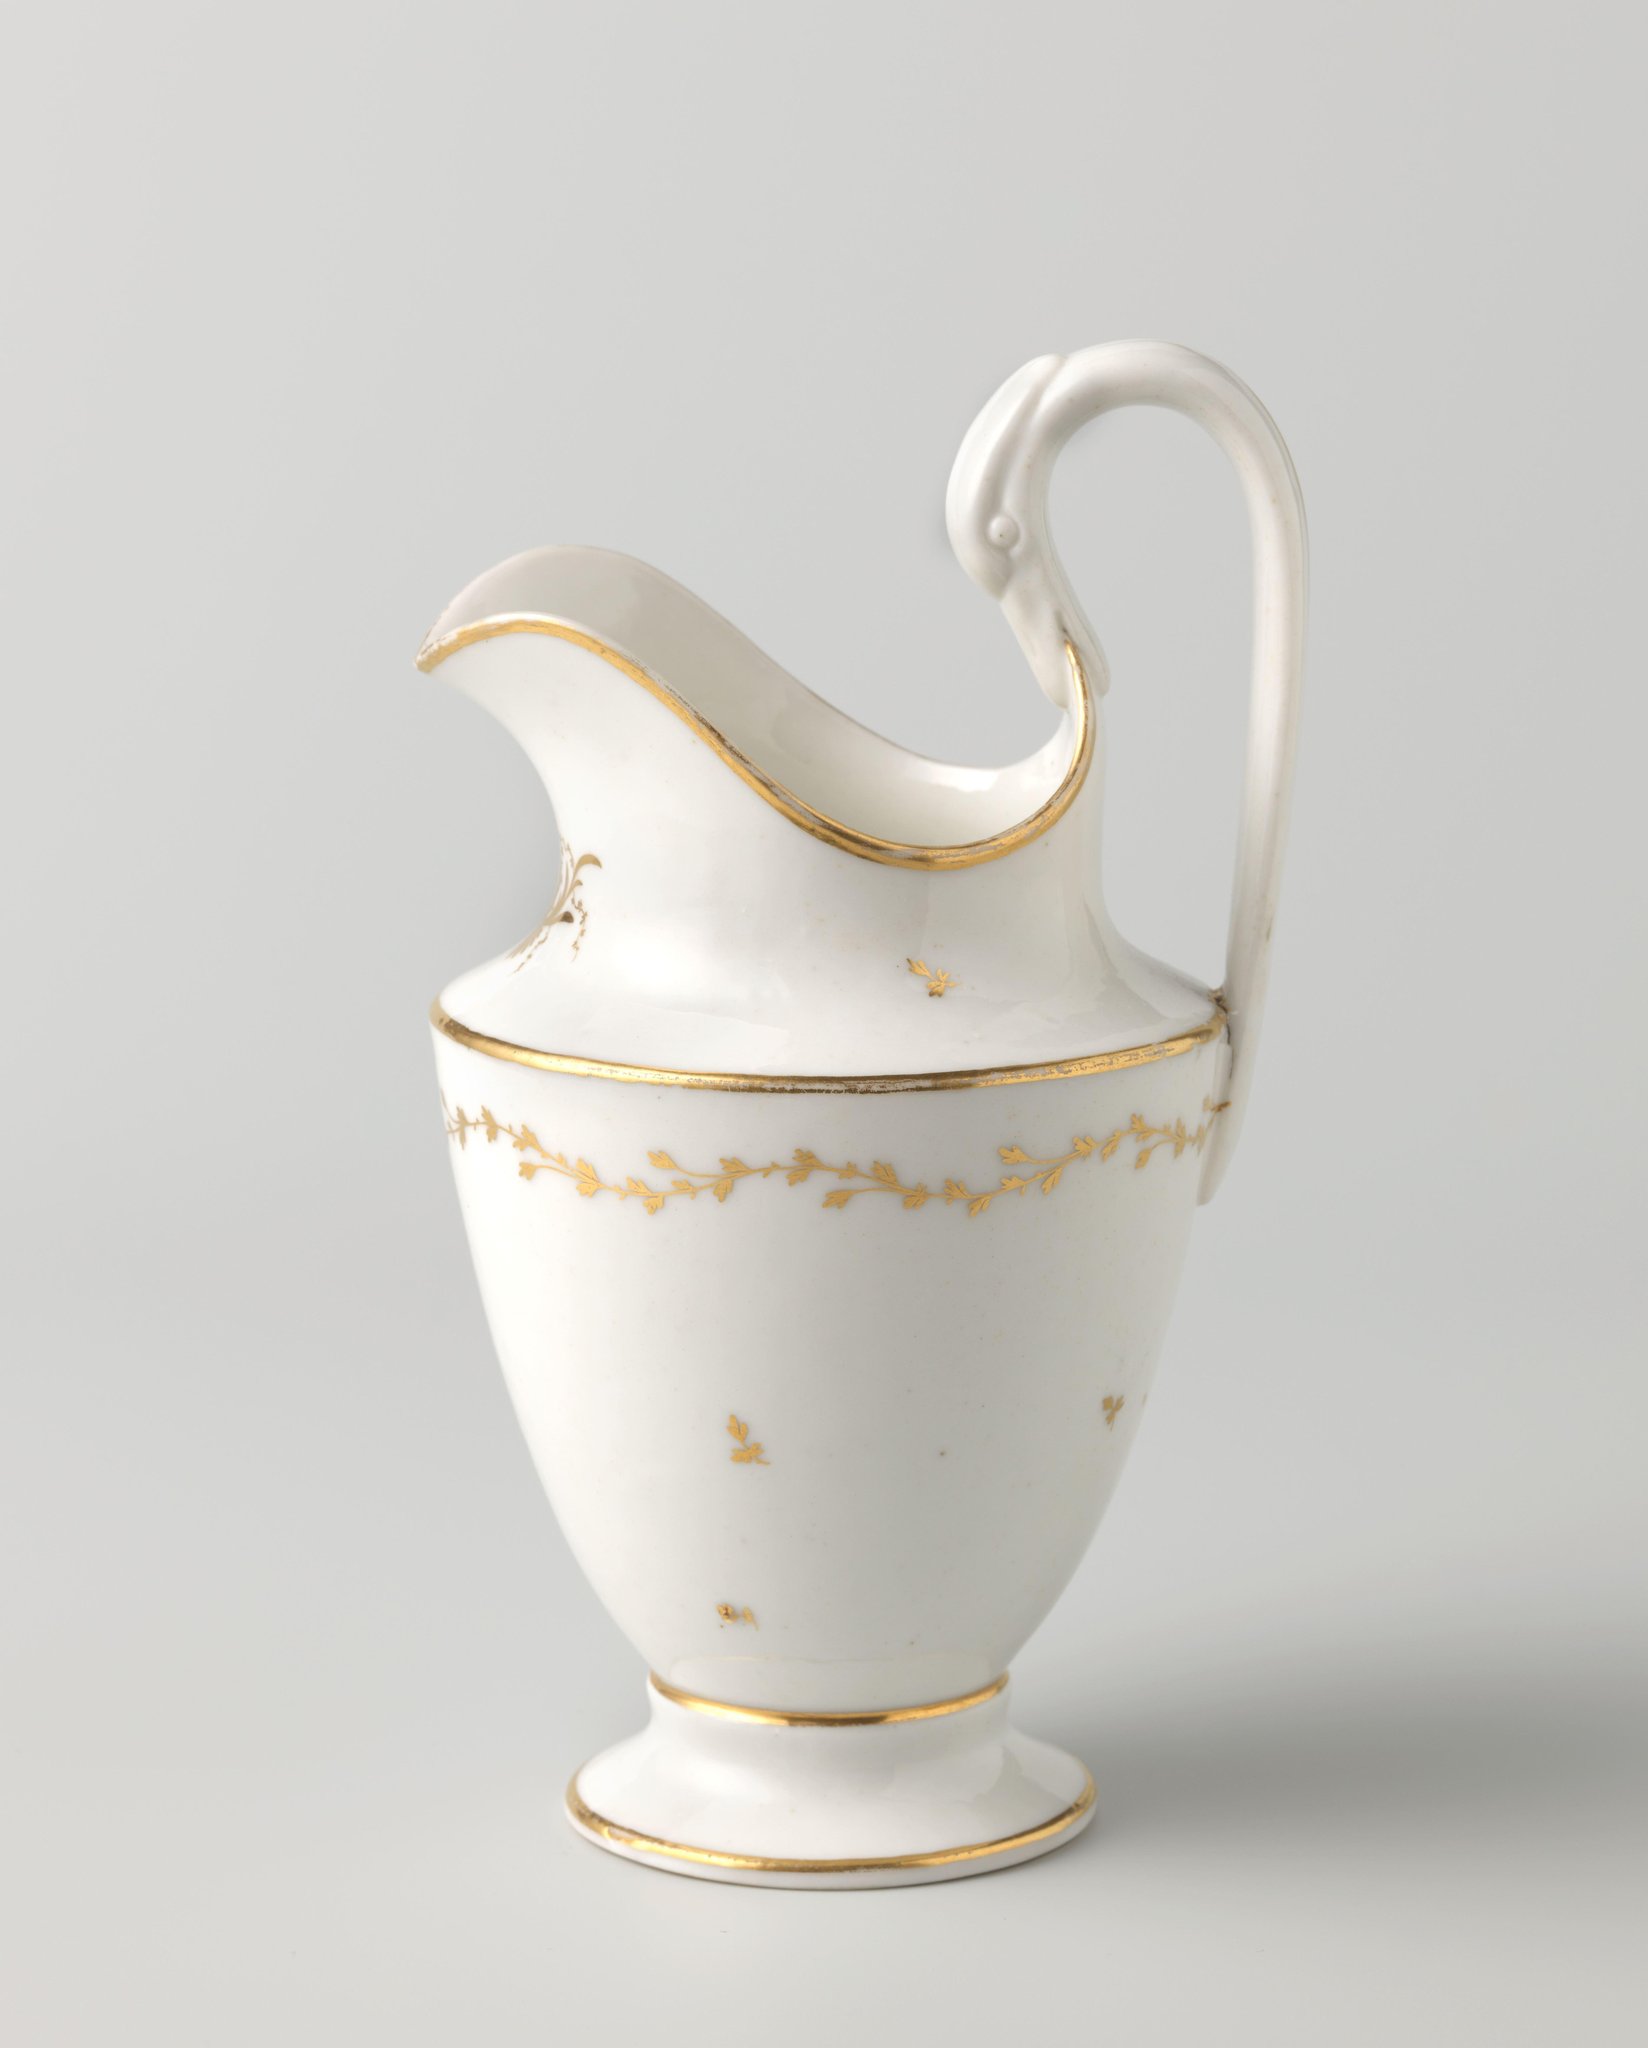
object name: milk jug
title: Melkkan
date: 1809-1814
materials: porcelain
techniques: painted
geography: nieuwer-amstel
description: Melkkan met gouden biezen langs de randen. Het oor van de melkkan heeft de vorm van een zwaan waarvan de kop in de rand van de kan bijt.